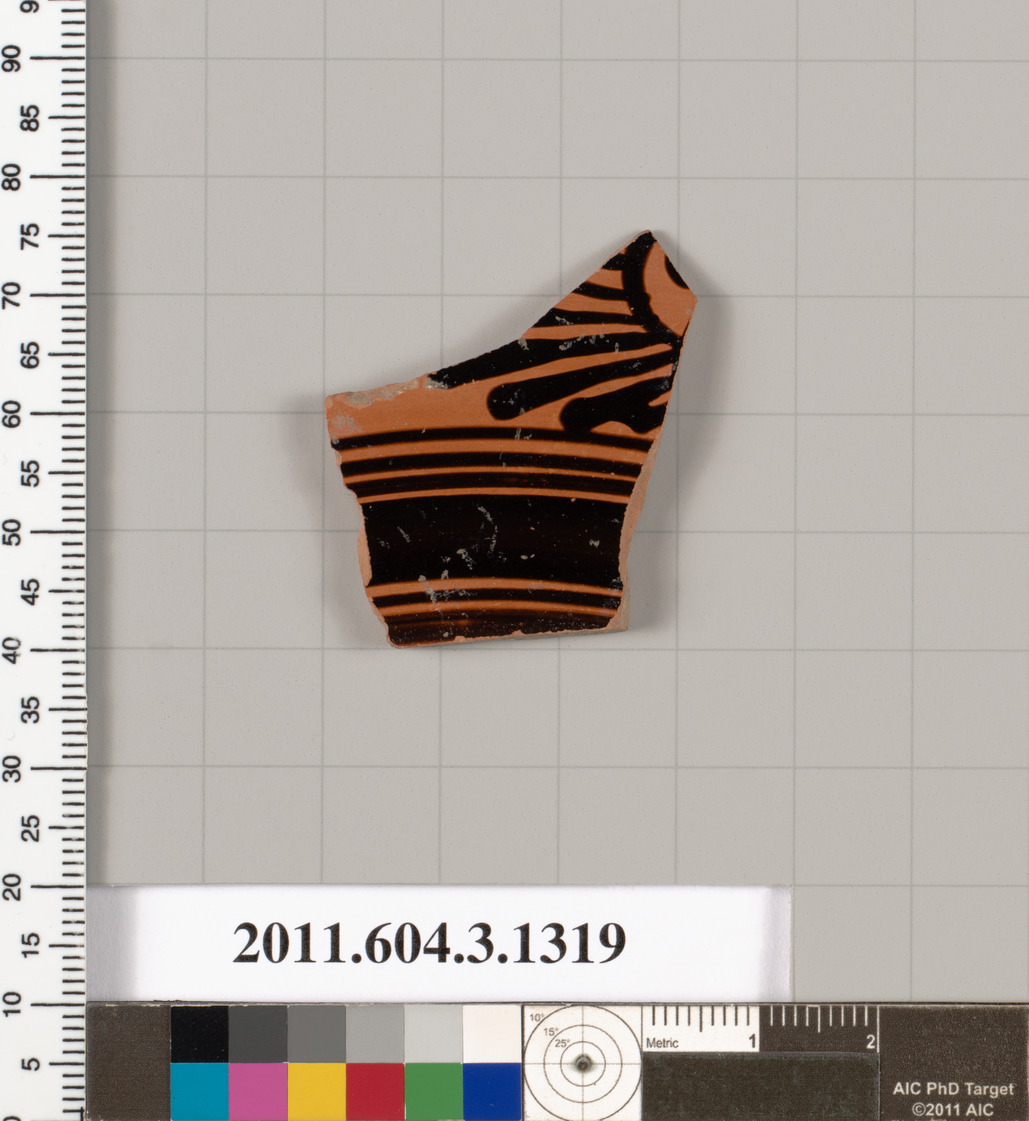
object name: skyphos fragment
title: Terracotta fragment of a skyphos (deep drinking cup)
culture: greek, attic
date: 490-480 BCE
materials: terracotta